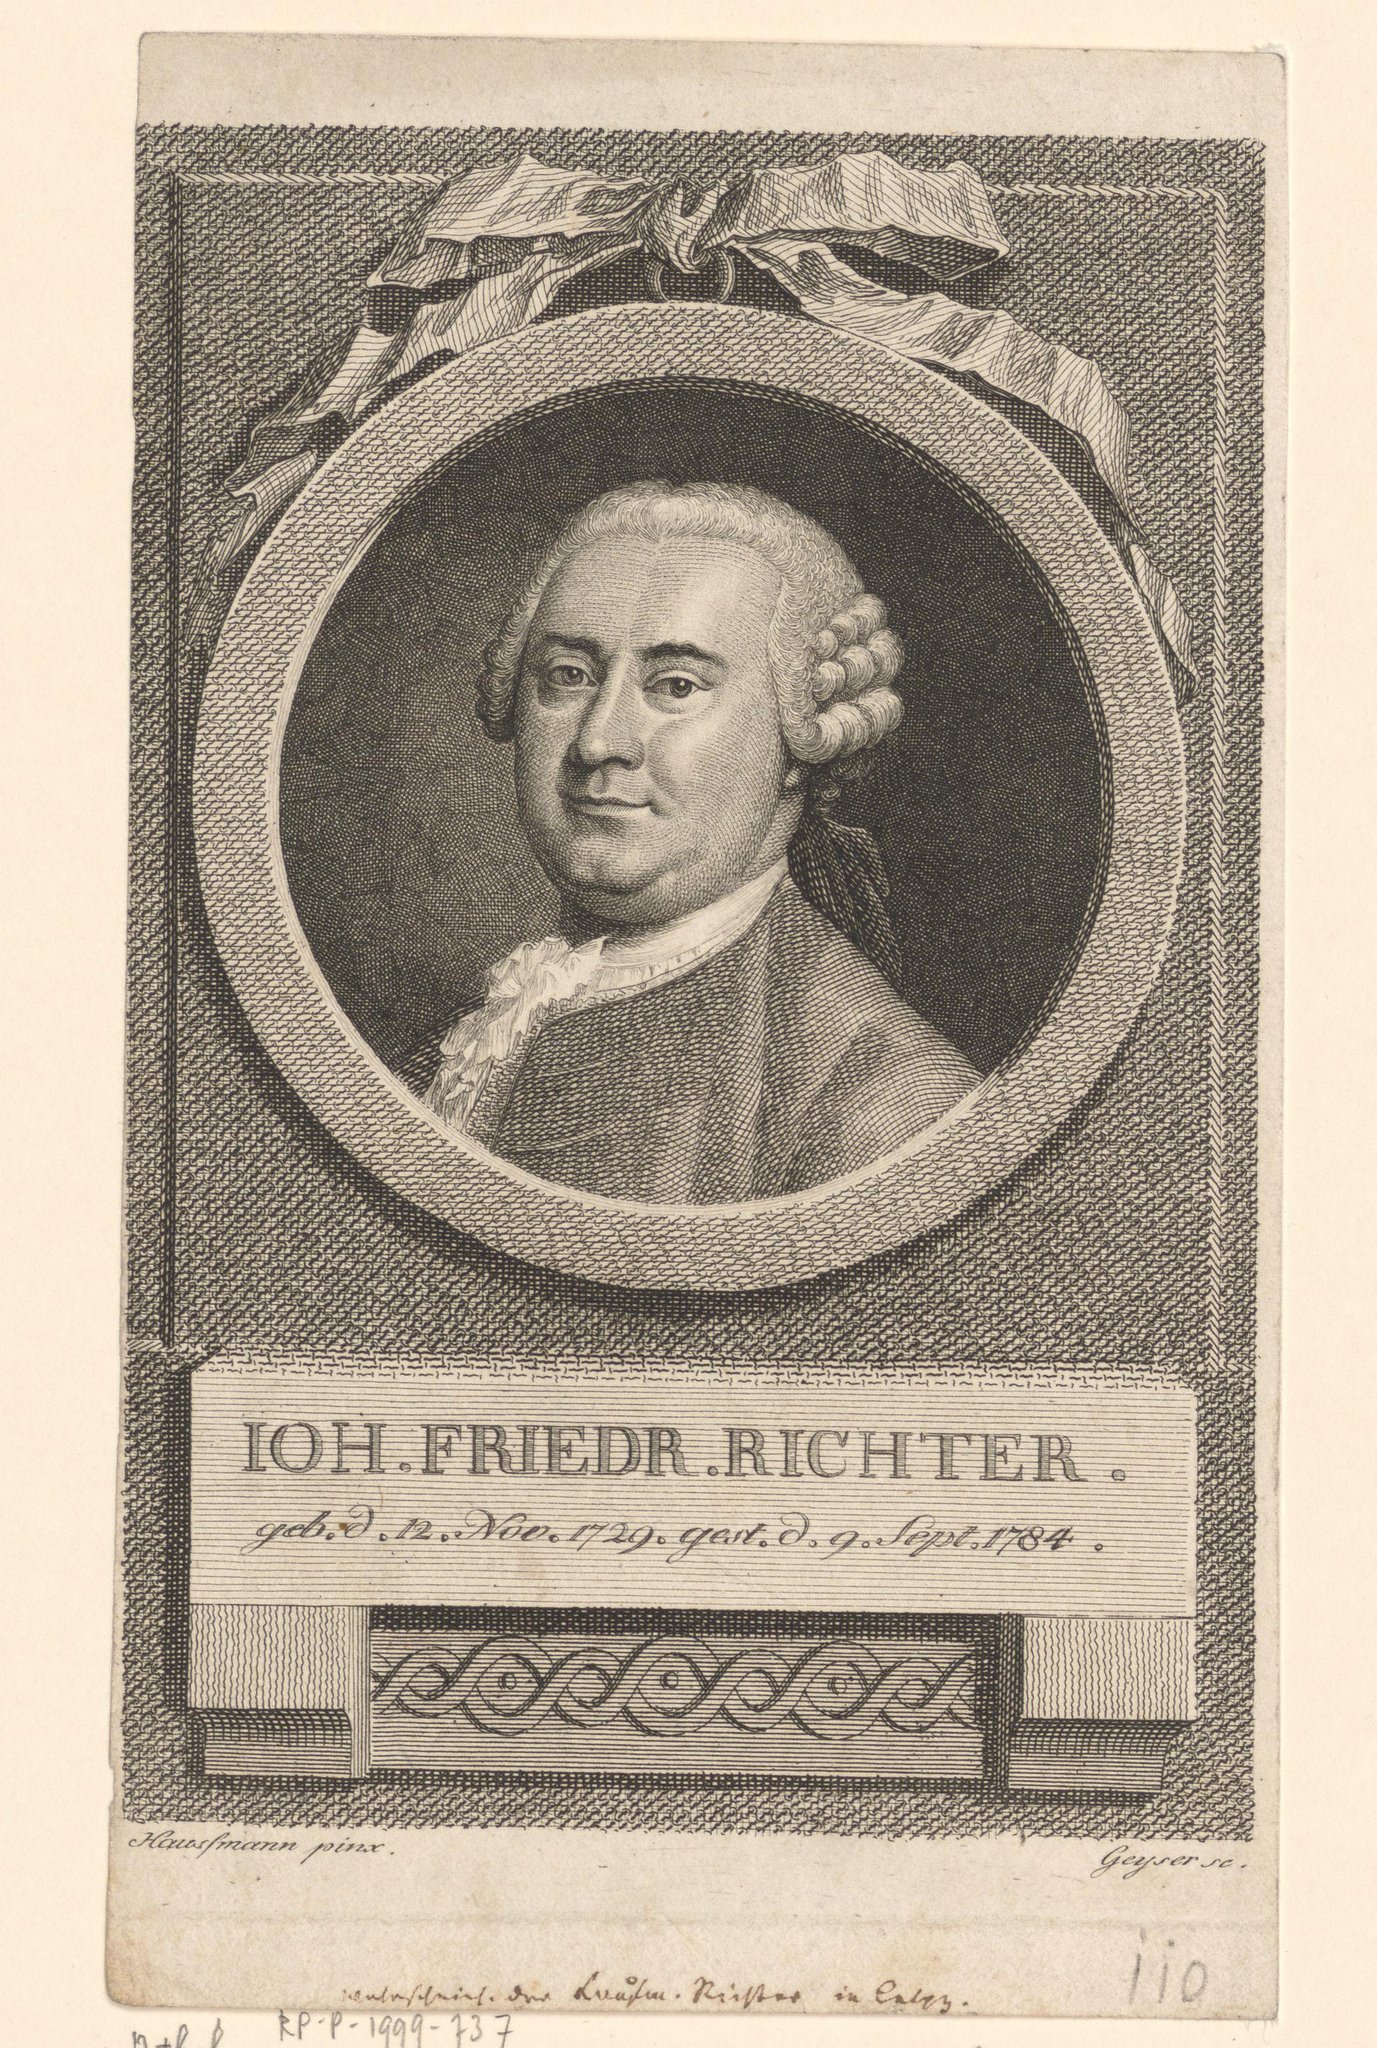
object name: print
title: Portret van Johann Friedrich Richter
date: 1784-1803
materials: paper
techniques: engraving, etching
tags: historical persons, merchant, salesman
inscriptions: collector's mark: Lugt 2228